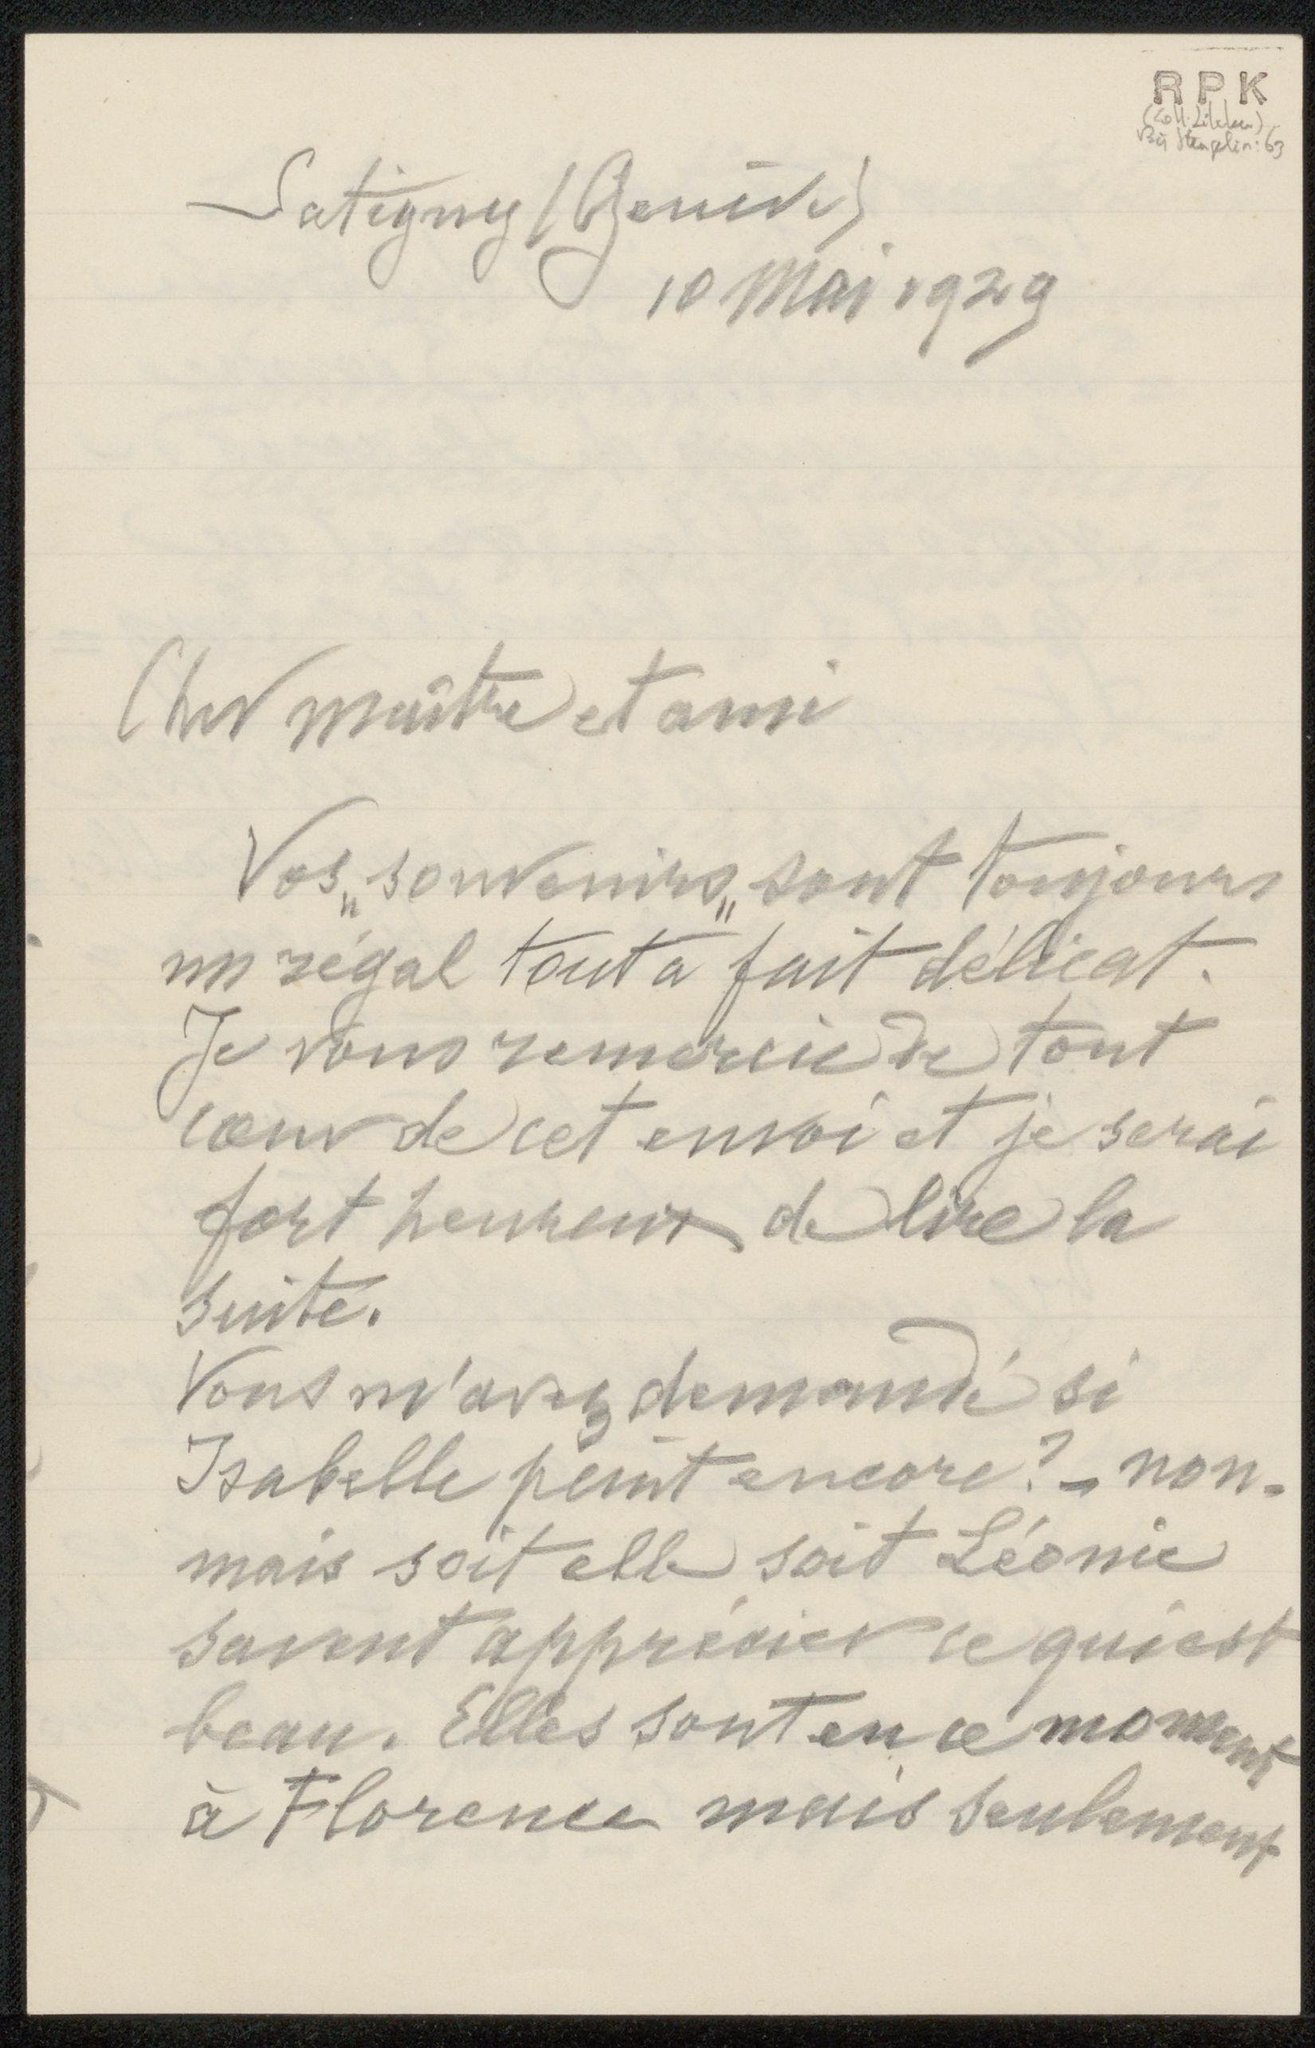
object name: letter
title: Brief aan Philip Zilcken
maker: alphonse stengelin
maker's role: painter, print maker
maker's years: 1852-1938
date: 1929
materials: pencil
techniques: writing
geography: satigny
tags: rembrandt van rijn, painter, draughtsman, philip zilcken, drawing, music, family life, painting (including book-illumination, miniature-painting), architecture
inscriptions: collector's mark: ‘RPK’